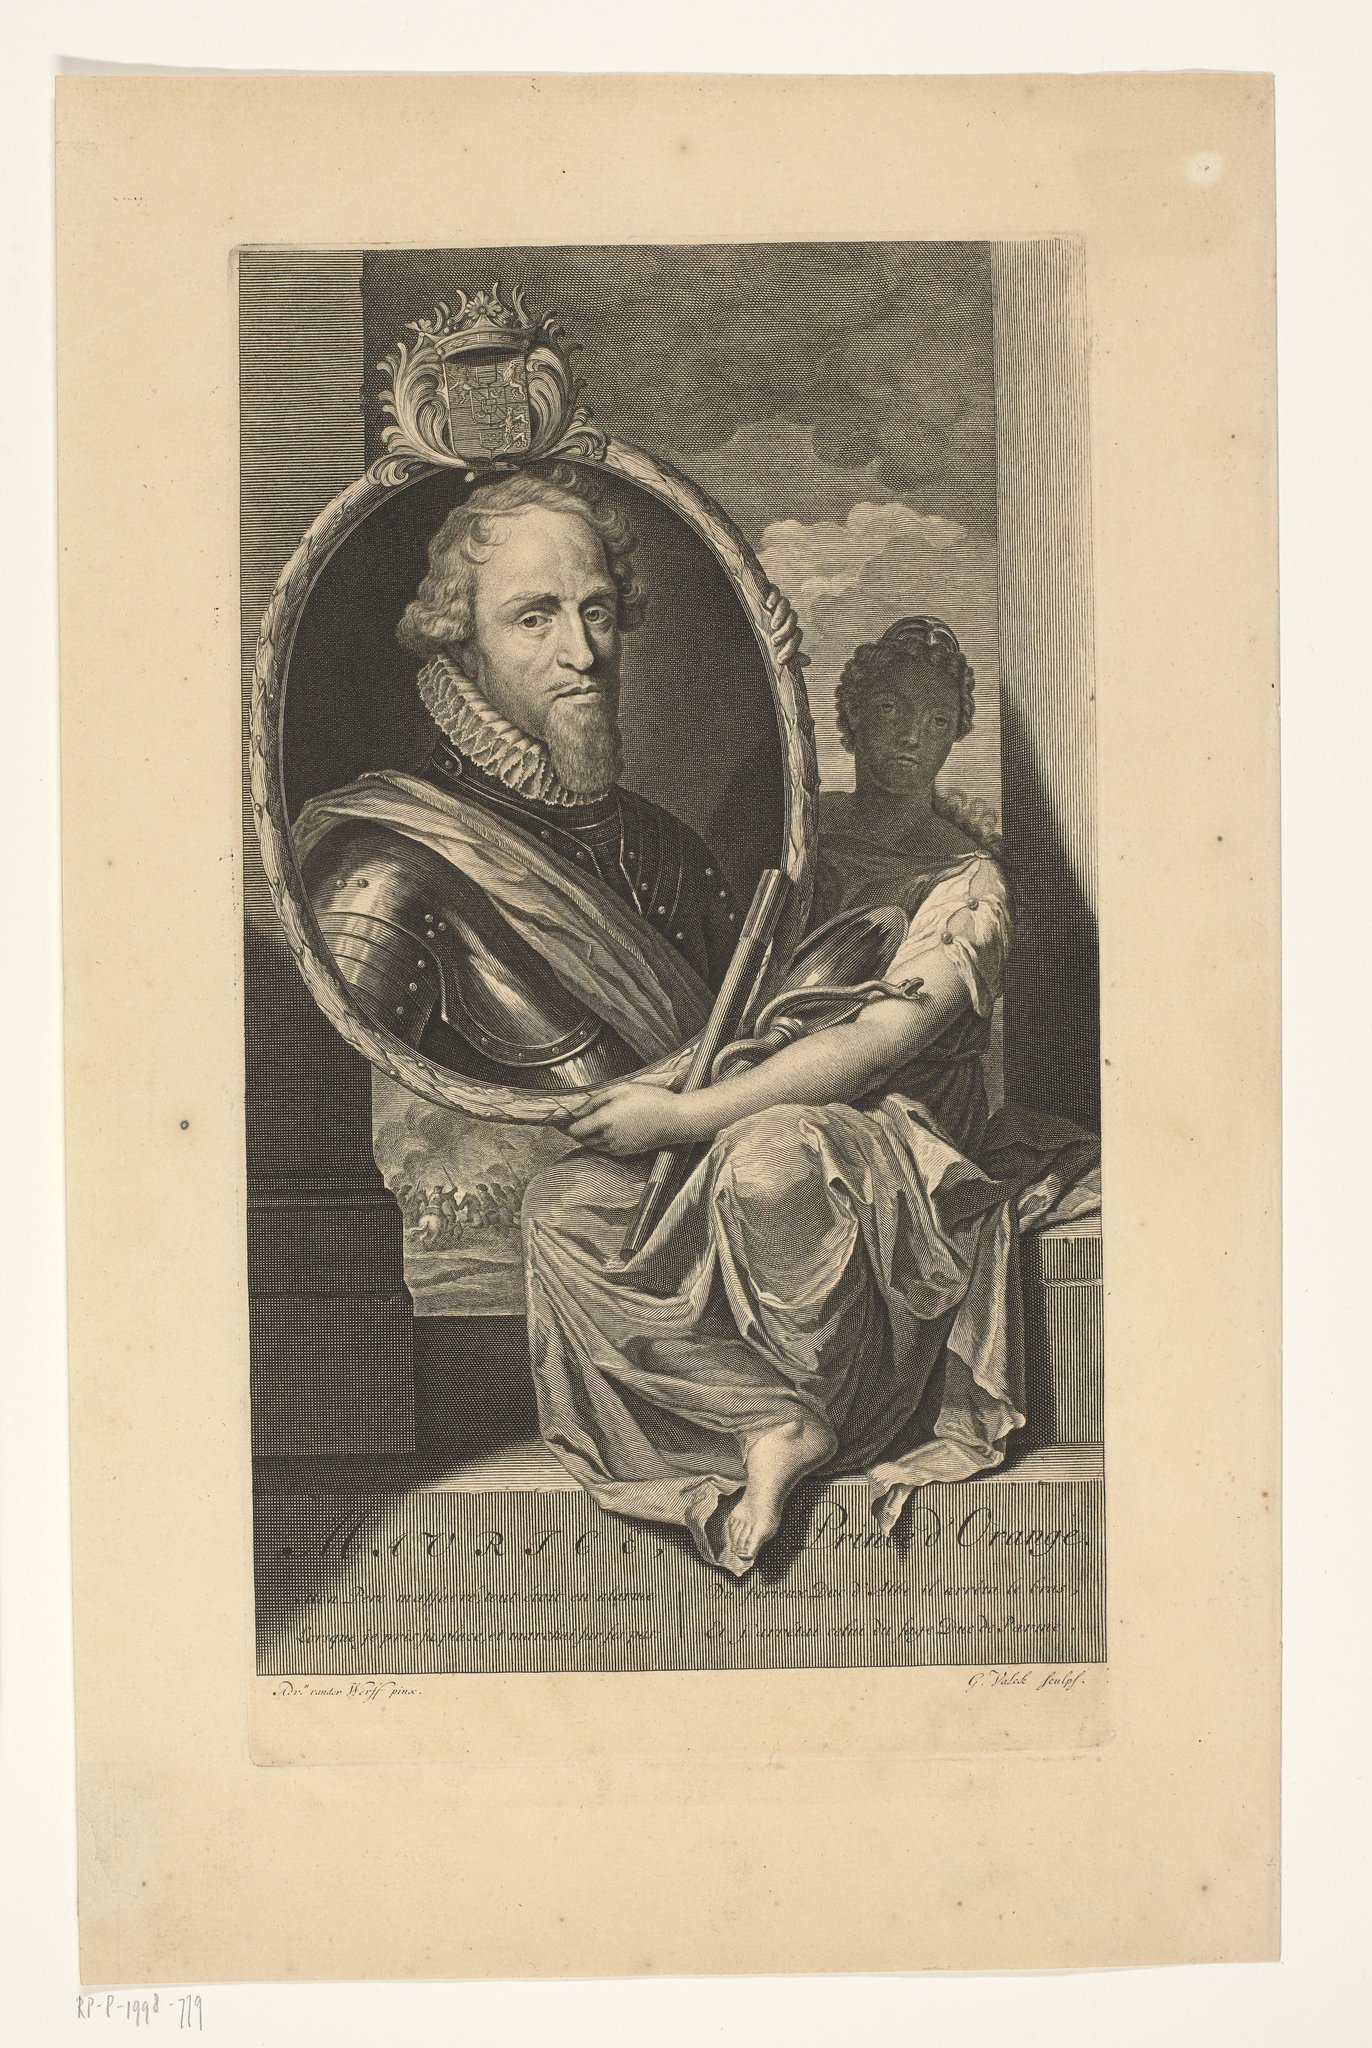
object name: print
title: Portret van Maurits, prins van Oranje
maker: adriaen van der werff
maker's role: draughtsman, painter, print maker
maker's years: 1659-1722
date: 1697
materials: paper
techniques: engraving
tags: the hague, maurice (prince of orange)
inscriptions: signature and date: ‘r.o. : G. Valck sculp.; l.o.: Adr. vander Werff pinx.’, collector's mark: Lugt 2228, inscription: ‘m.o.: MAURICE, Prince d'Orange // Mon Père...Duc de Parme.’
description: Portret van Maurits, Prins van Oranje, dat wordt vastgehouden door een allegorische vrouwenfiguur, zittend tussen twee zuilen, met slan, spiegel en commandostaf. Inde achtergrond een veldslag. Met onderschrift over Alva en de hertog van Parma. Prent uit een serie van zeven portretten van historische figuren.